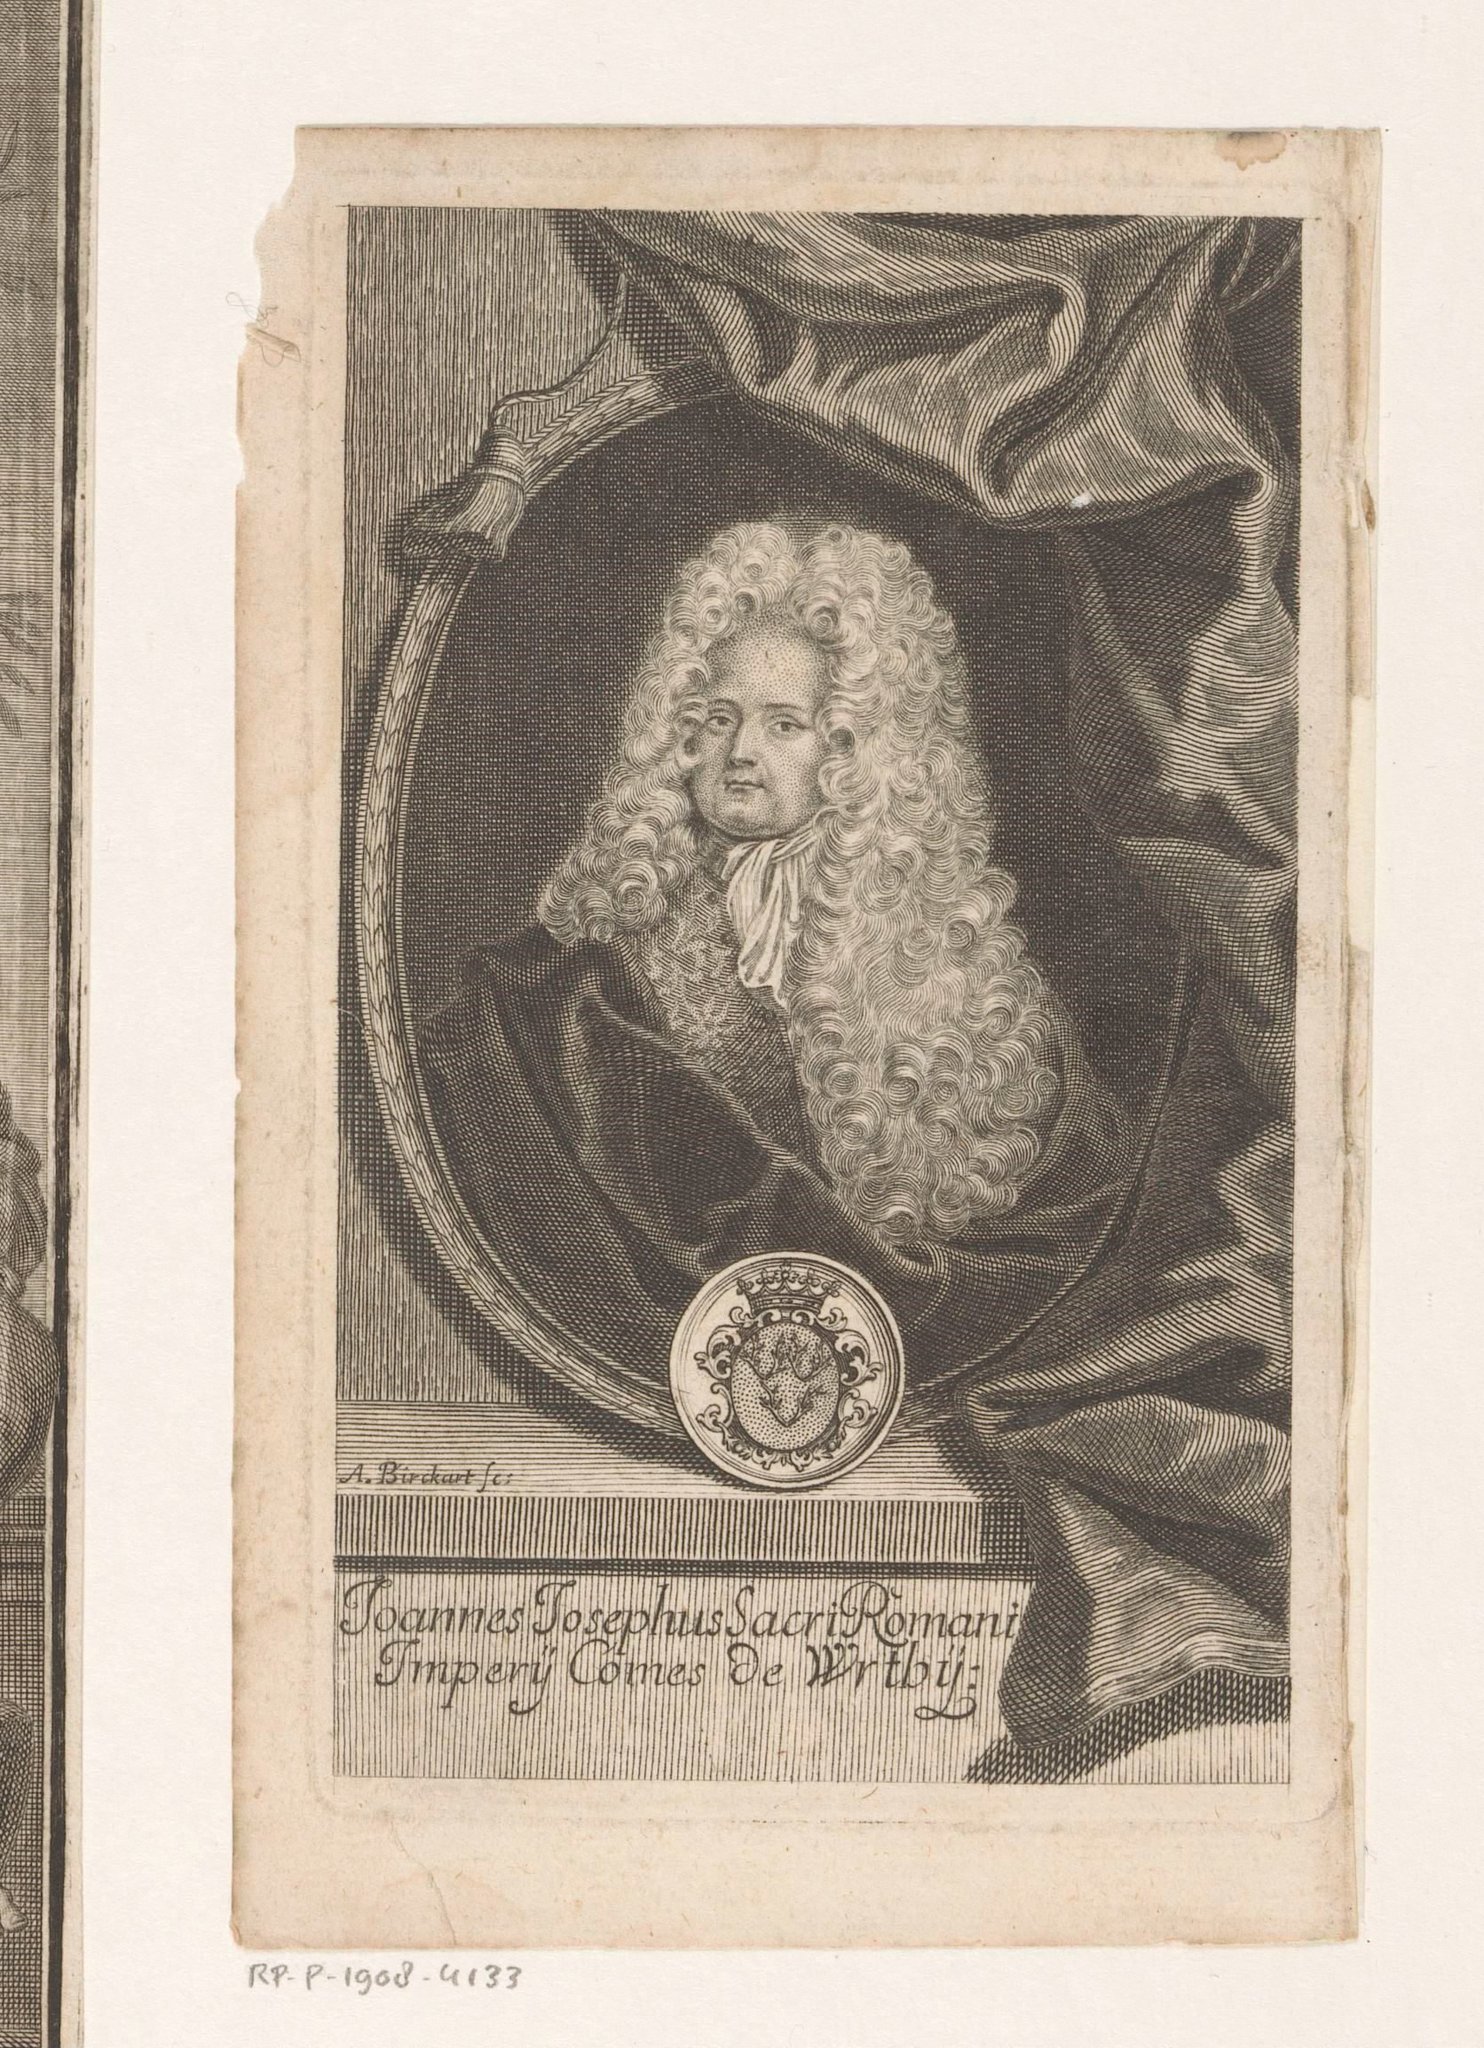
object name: print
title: Portret van Johann Joseph, Reichsgraf von Wrtby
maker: anton birckhart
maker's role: print maker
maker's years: 1677-1748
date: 1687-1748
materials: paper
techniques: engraving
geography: prague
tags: historical persons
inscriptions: collector's mark: Lugt 2228